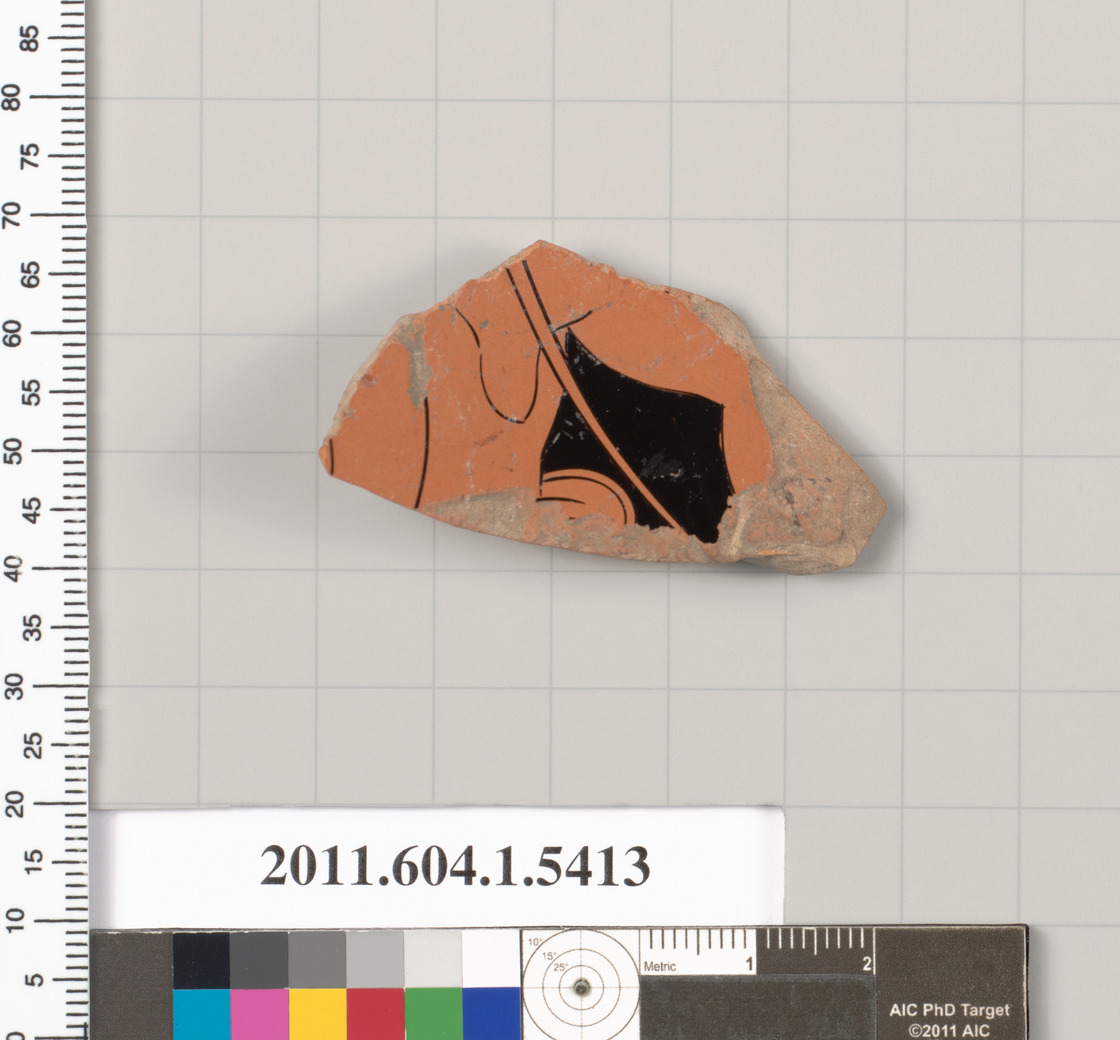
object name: kylix fragment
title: Terracotta fragment of a kylix (drinking cup)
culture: greek, attic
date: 490-480 BCE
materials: terracotta